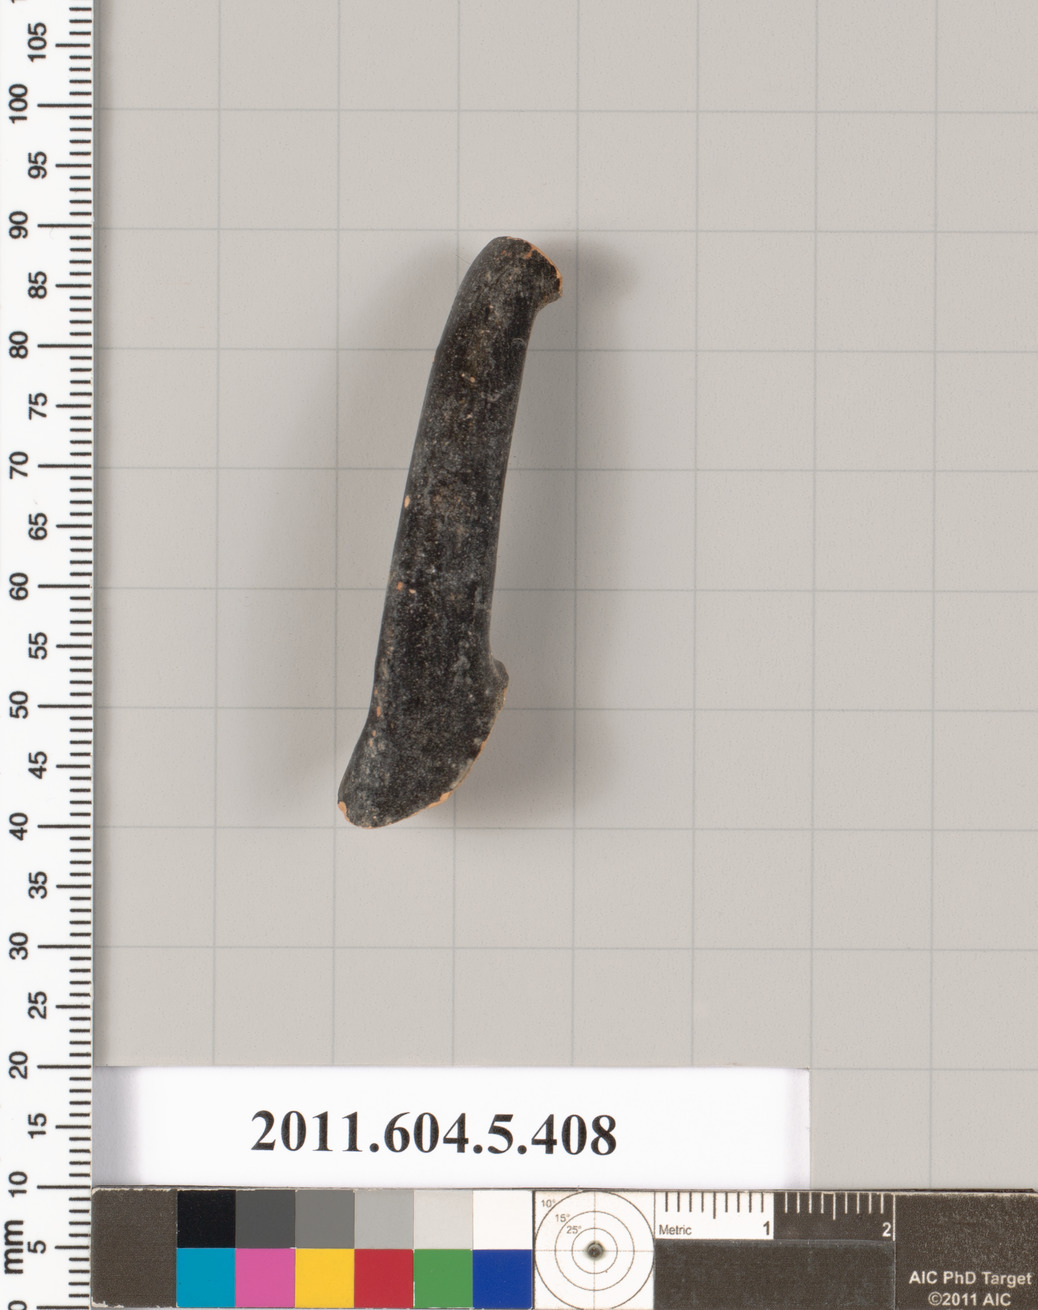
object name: kylix fragment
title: Terracotta fragment of a kylix (drinking cup)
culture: greek, attic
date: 600-401 BCE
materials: terracotta